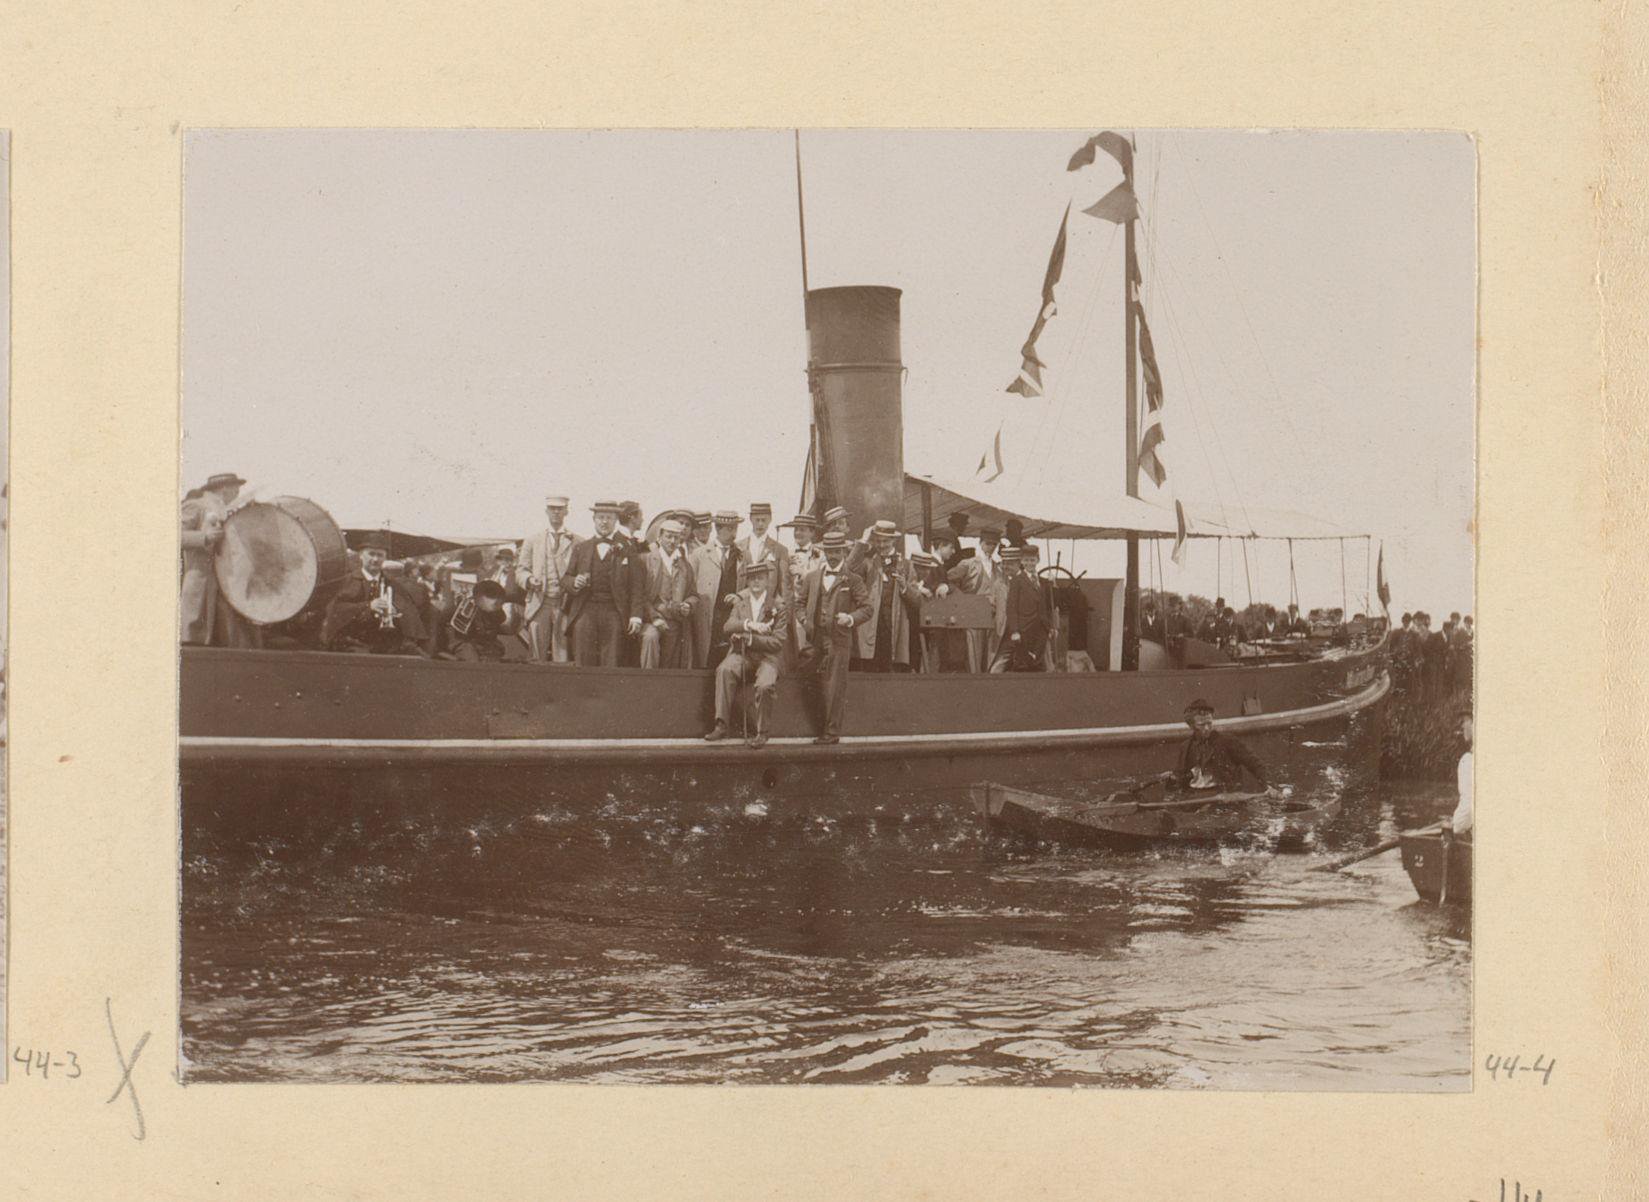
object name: album leaf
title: Gezelschap op versierde boten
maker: hendrik herman van den berg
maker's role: amateurfotograaf, jurist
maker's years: 1875-1944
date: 1890-1894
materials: paper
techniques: collodion silver print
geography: amsterdam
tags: historical persons, ships (in general), amsterdam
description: Foto 4 op albumblad 44 uit album "Amsterdam 1890-1894".